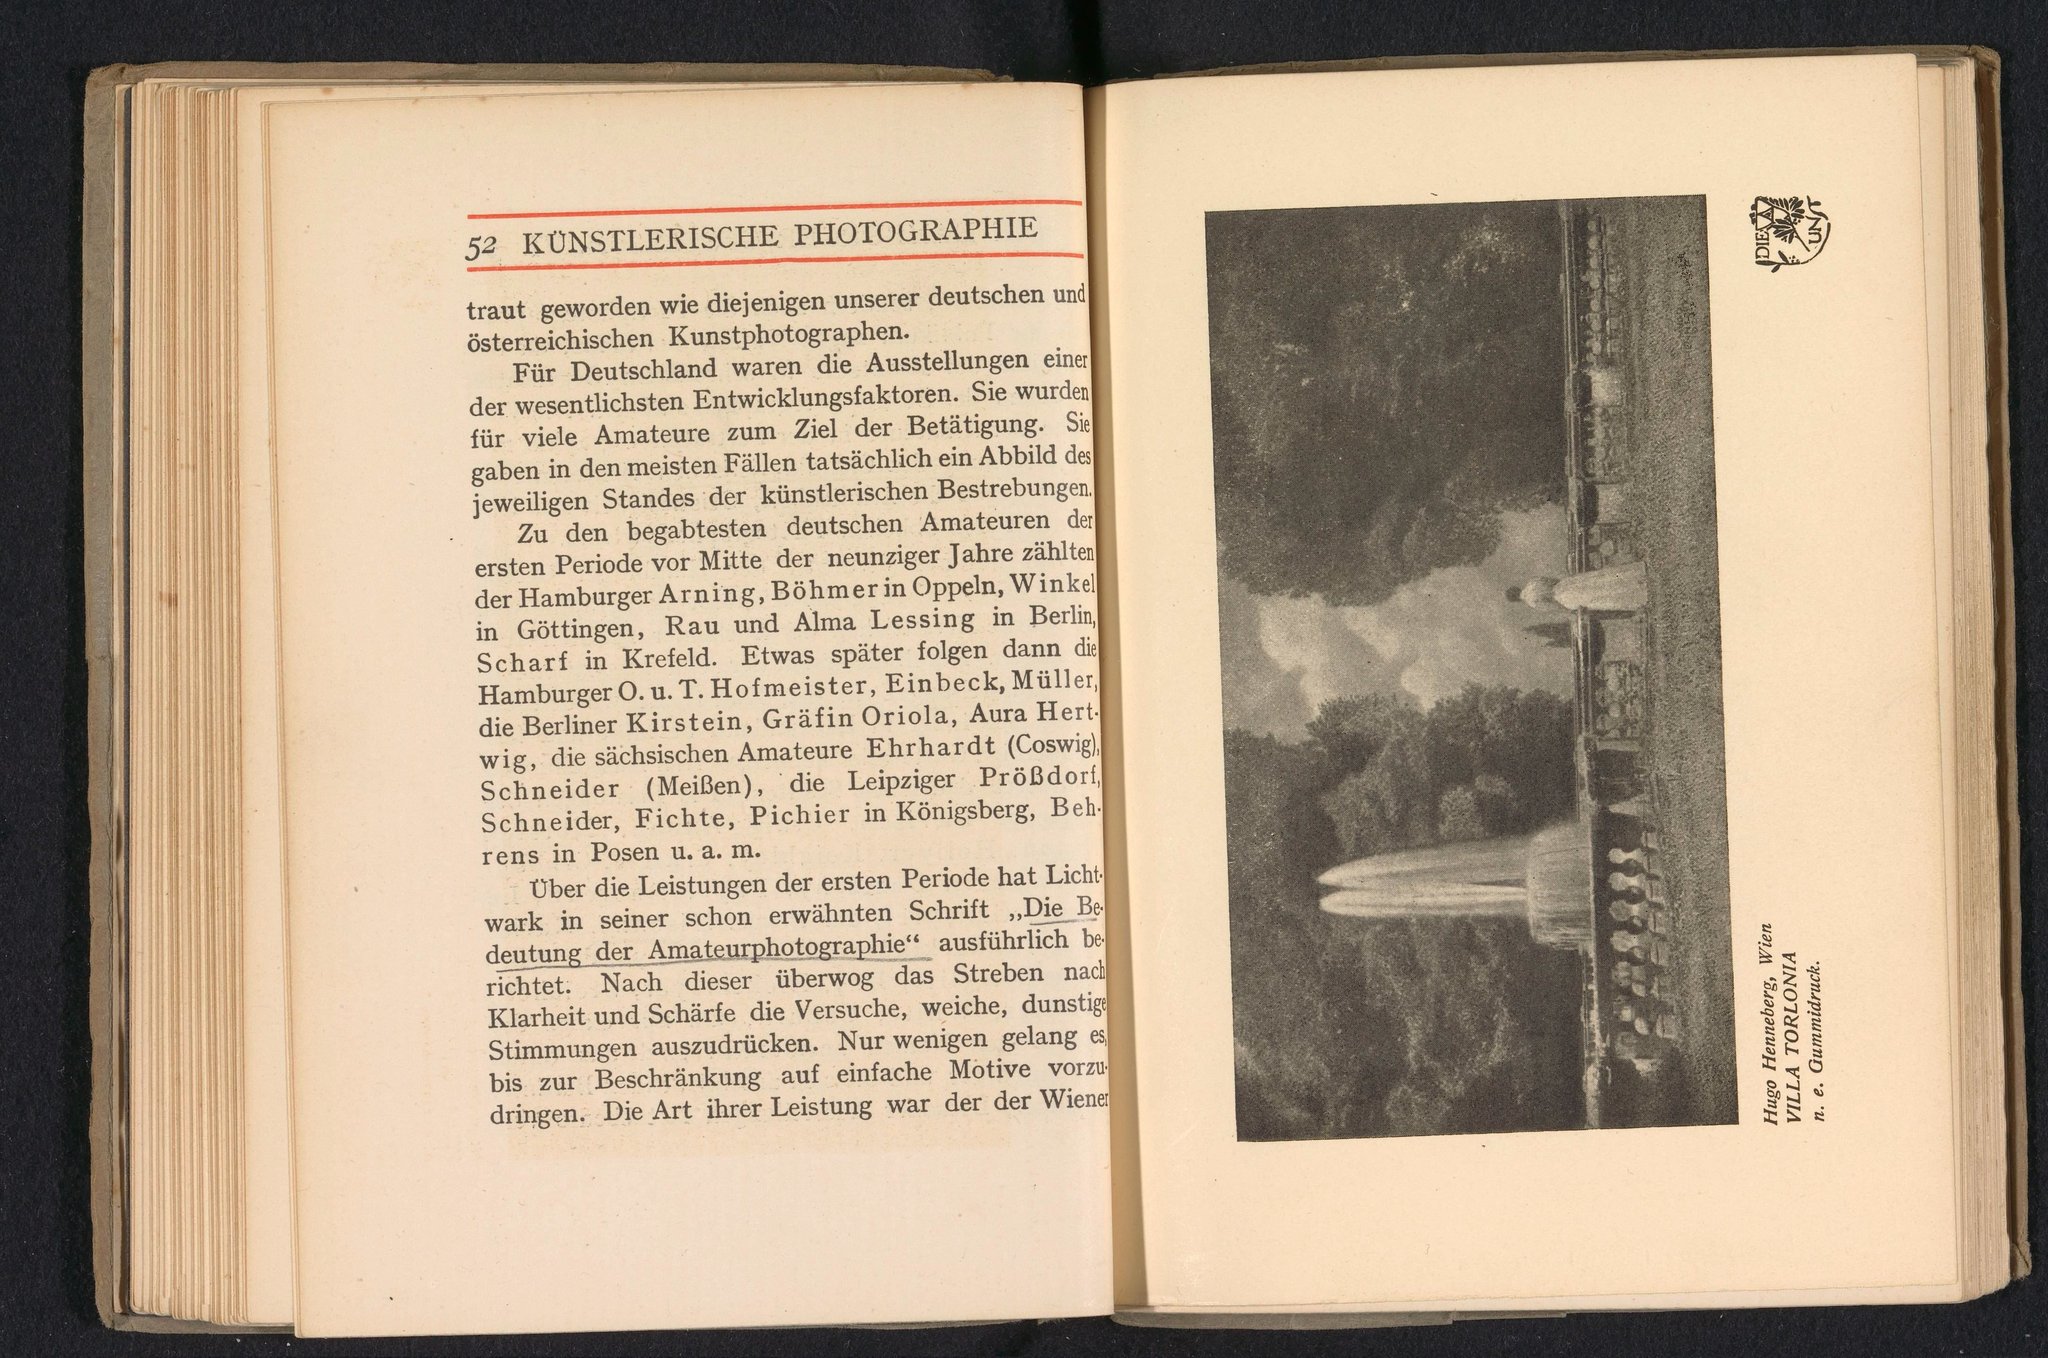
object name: photomechanical print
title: Fotoreproductie van een foto door Hugo Henneberg, voorstellend de tuin van Villa Torlonia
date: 1880-1907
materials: paper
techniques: autotype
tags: garden, villa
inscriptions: inscription: ‘n.e. Gummidruck.’